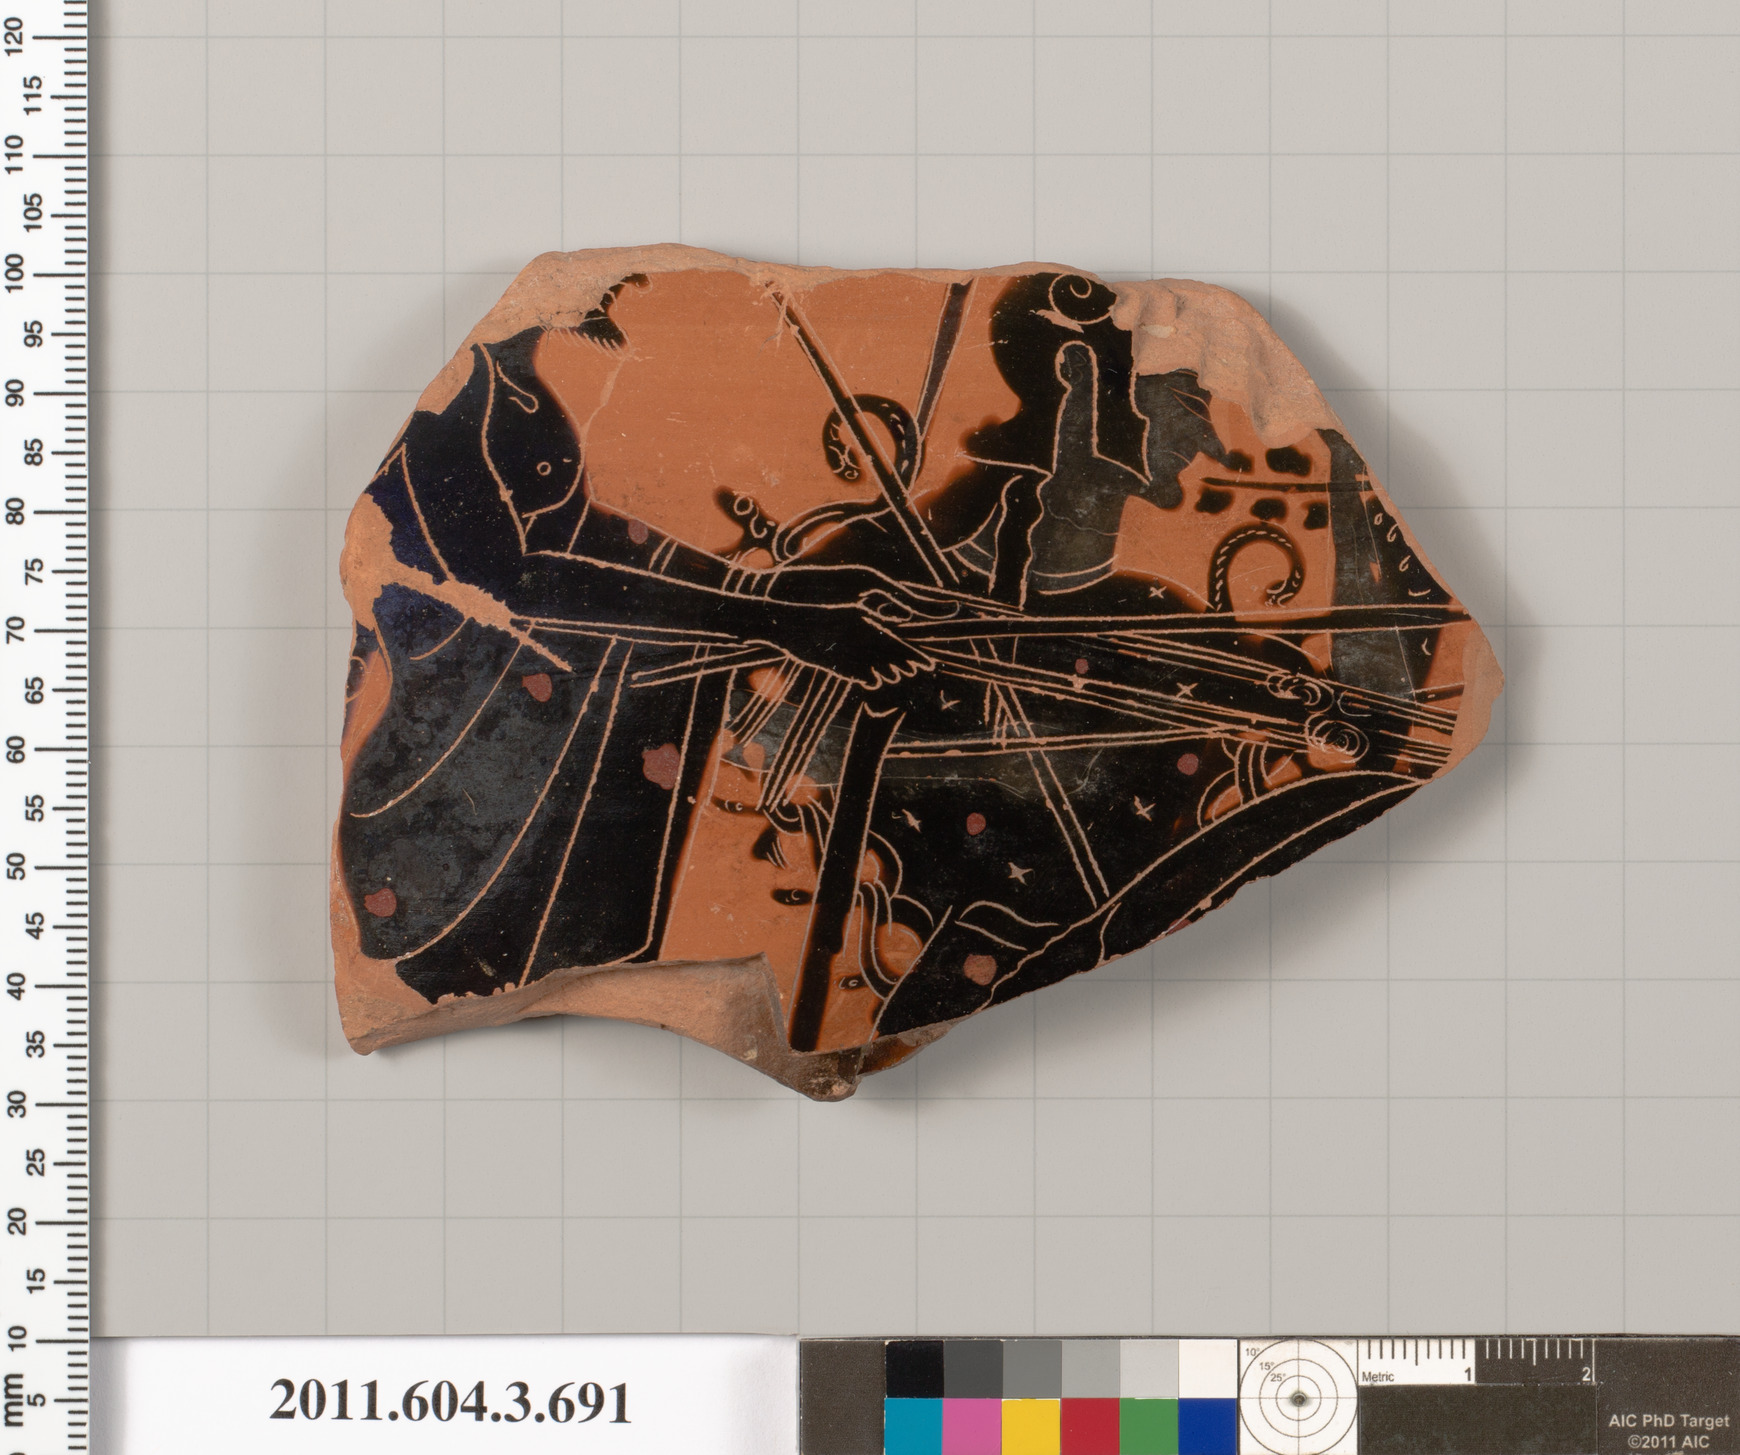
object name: hydria fragment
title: Terracotta fragment of a hydria (water jar)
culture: greek, attic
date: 525-501 BCE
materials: terracotta